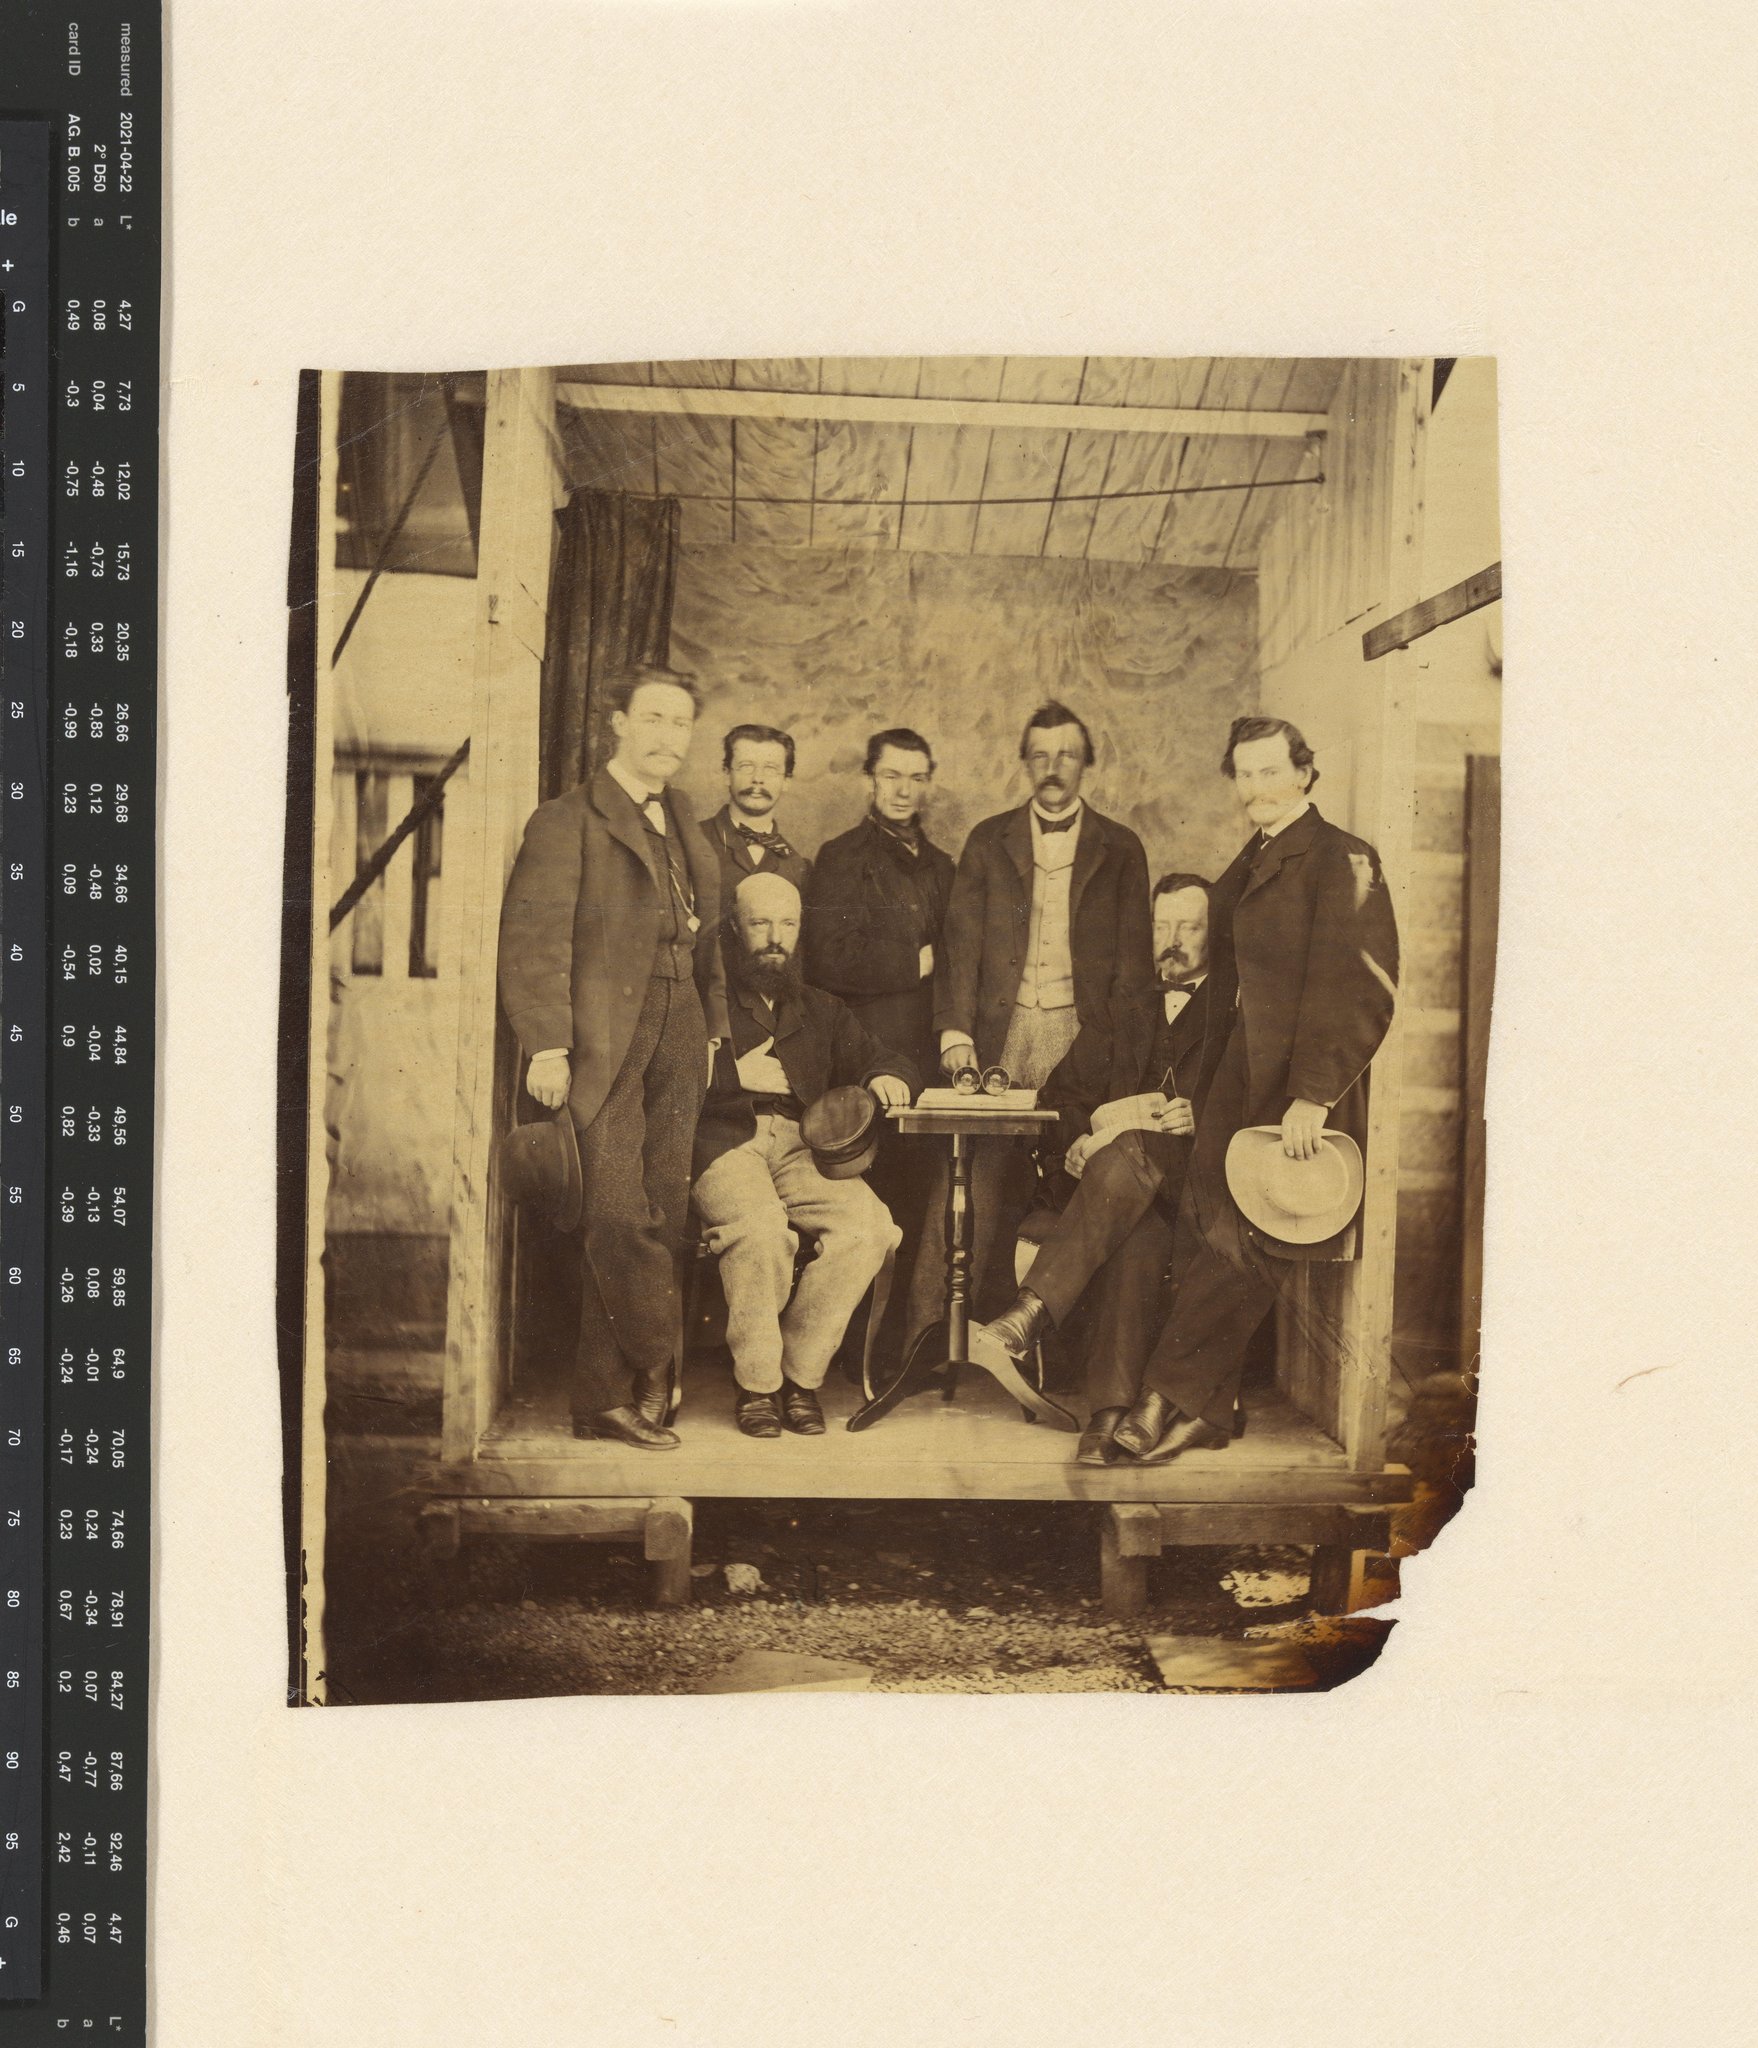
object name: photograph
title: Group portrait of seven men on Dejima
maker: antoon bauduin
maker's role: amateurfotograaf, hoogleraar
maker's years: 1820-1885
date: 1862-1866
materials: paper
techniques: albumen print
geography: japan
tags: dordrecht, the hague, antoon bauduin, anonymous historical persons portrayed in a group, in a group-portrait, japan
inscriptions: number: ‘BD177’, number: ‘BL4’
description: Letters Albert sent home from Japan are our main source of information about the brothers’ lives in Japan. Because of these letters, we know that it was Antoon who took pictures there, but Albert may occasionally have lent a hand. Here we see them both in a simple, half-open studio in a garden on Dejima. Antoon is the one standing on the right, Albert is seated on the left.